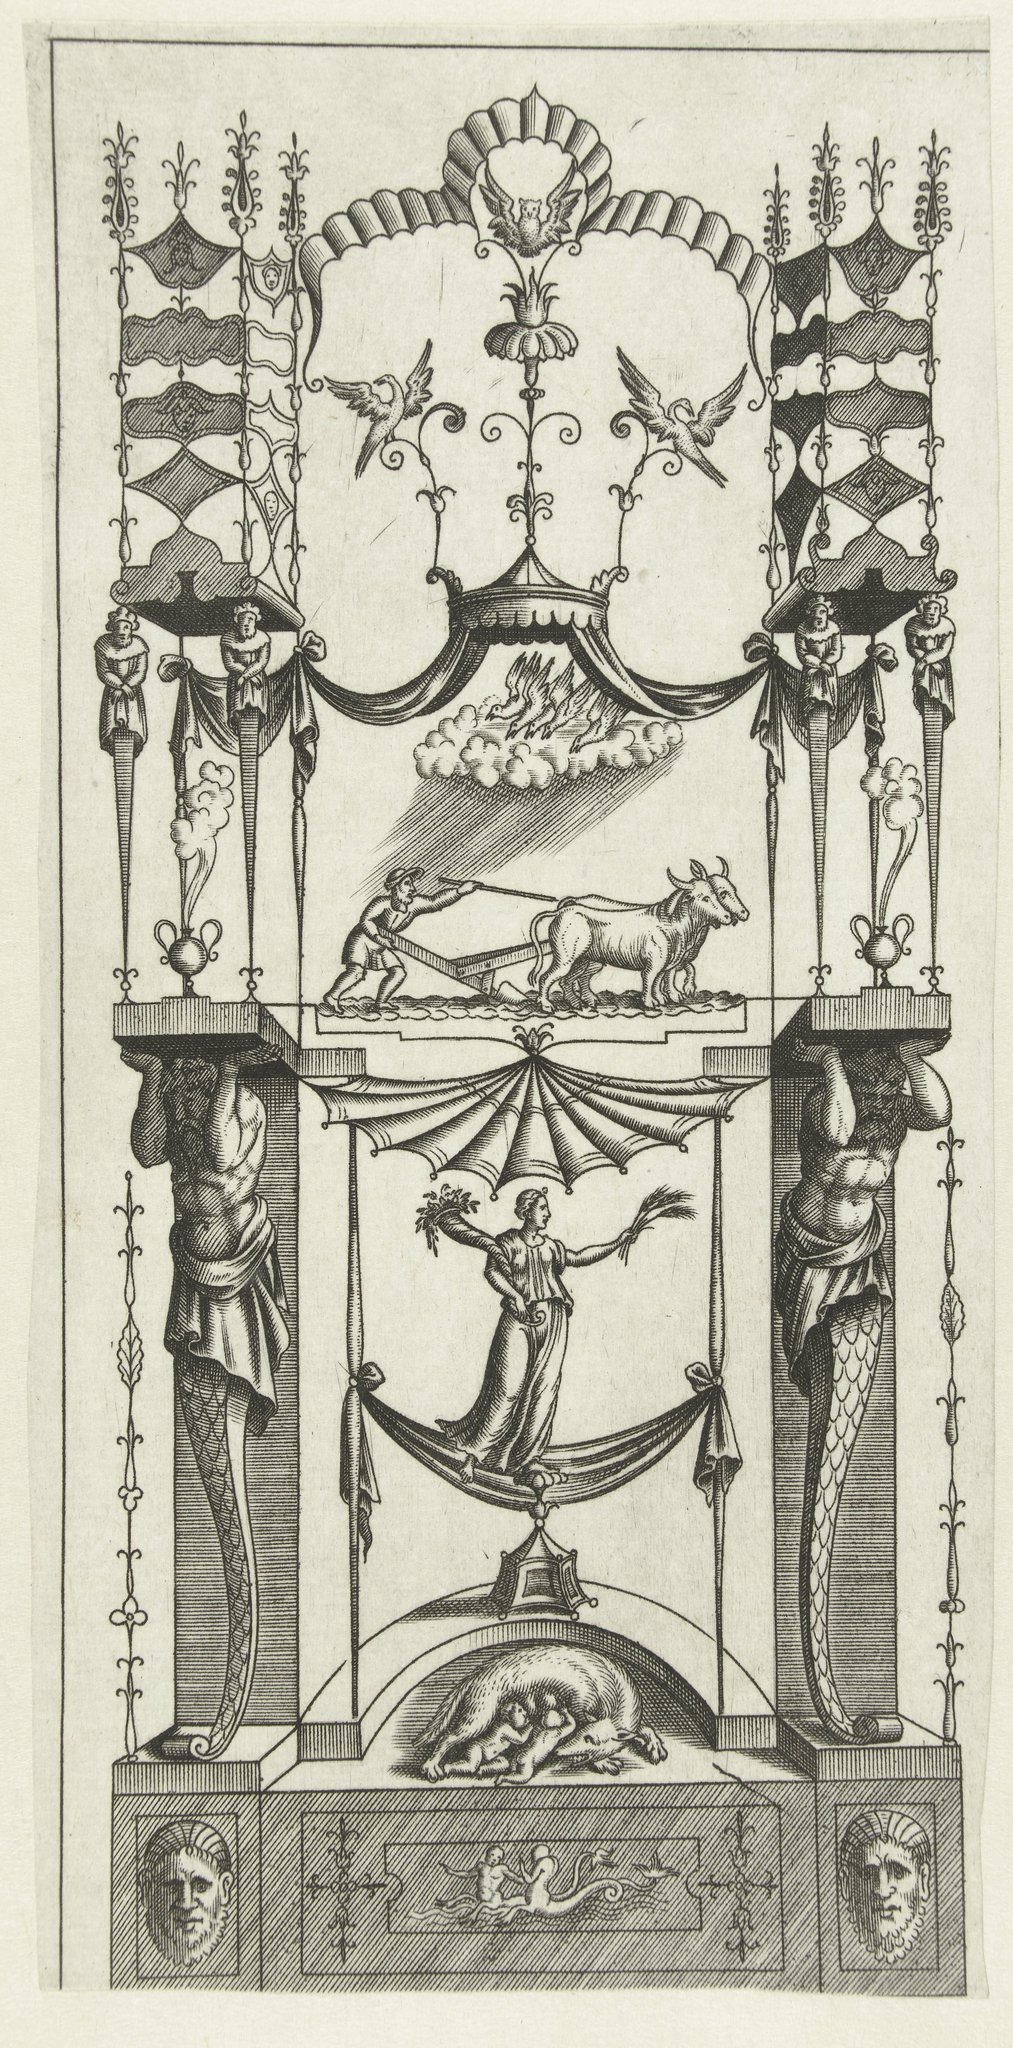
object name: ornament print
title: Leviores et ut videtur extemporaneae picturae quas grotteschas vulgo vocant (...)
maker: Anonymous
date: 1530-1540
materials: paper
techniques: engraving, etching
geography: italy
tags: (story of) romulus and remus, ornament derived from architectural details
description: Vlakdecoratie: open architectuurfantasie met twee hermen die de bovenstructuur van het gebouw dragen. Tussen hen in, onder een baldakijn, een vrouw met een hoorn des overvloeds en korenaren, staande op een draperie. Aan haar voeten Romulus en Remus, gevoed door de wolvin. Boven de personificatie van 'Terra' (of de vruchtbaarheid?) een ploegende boer onder een baldakijn. Uit serie van 20 bladen.